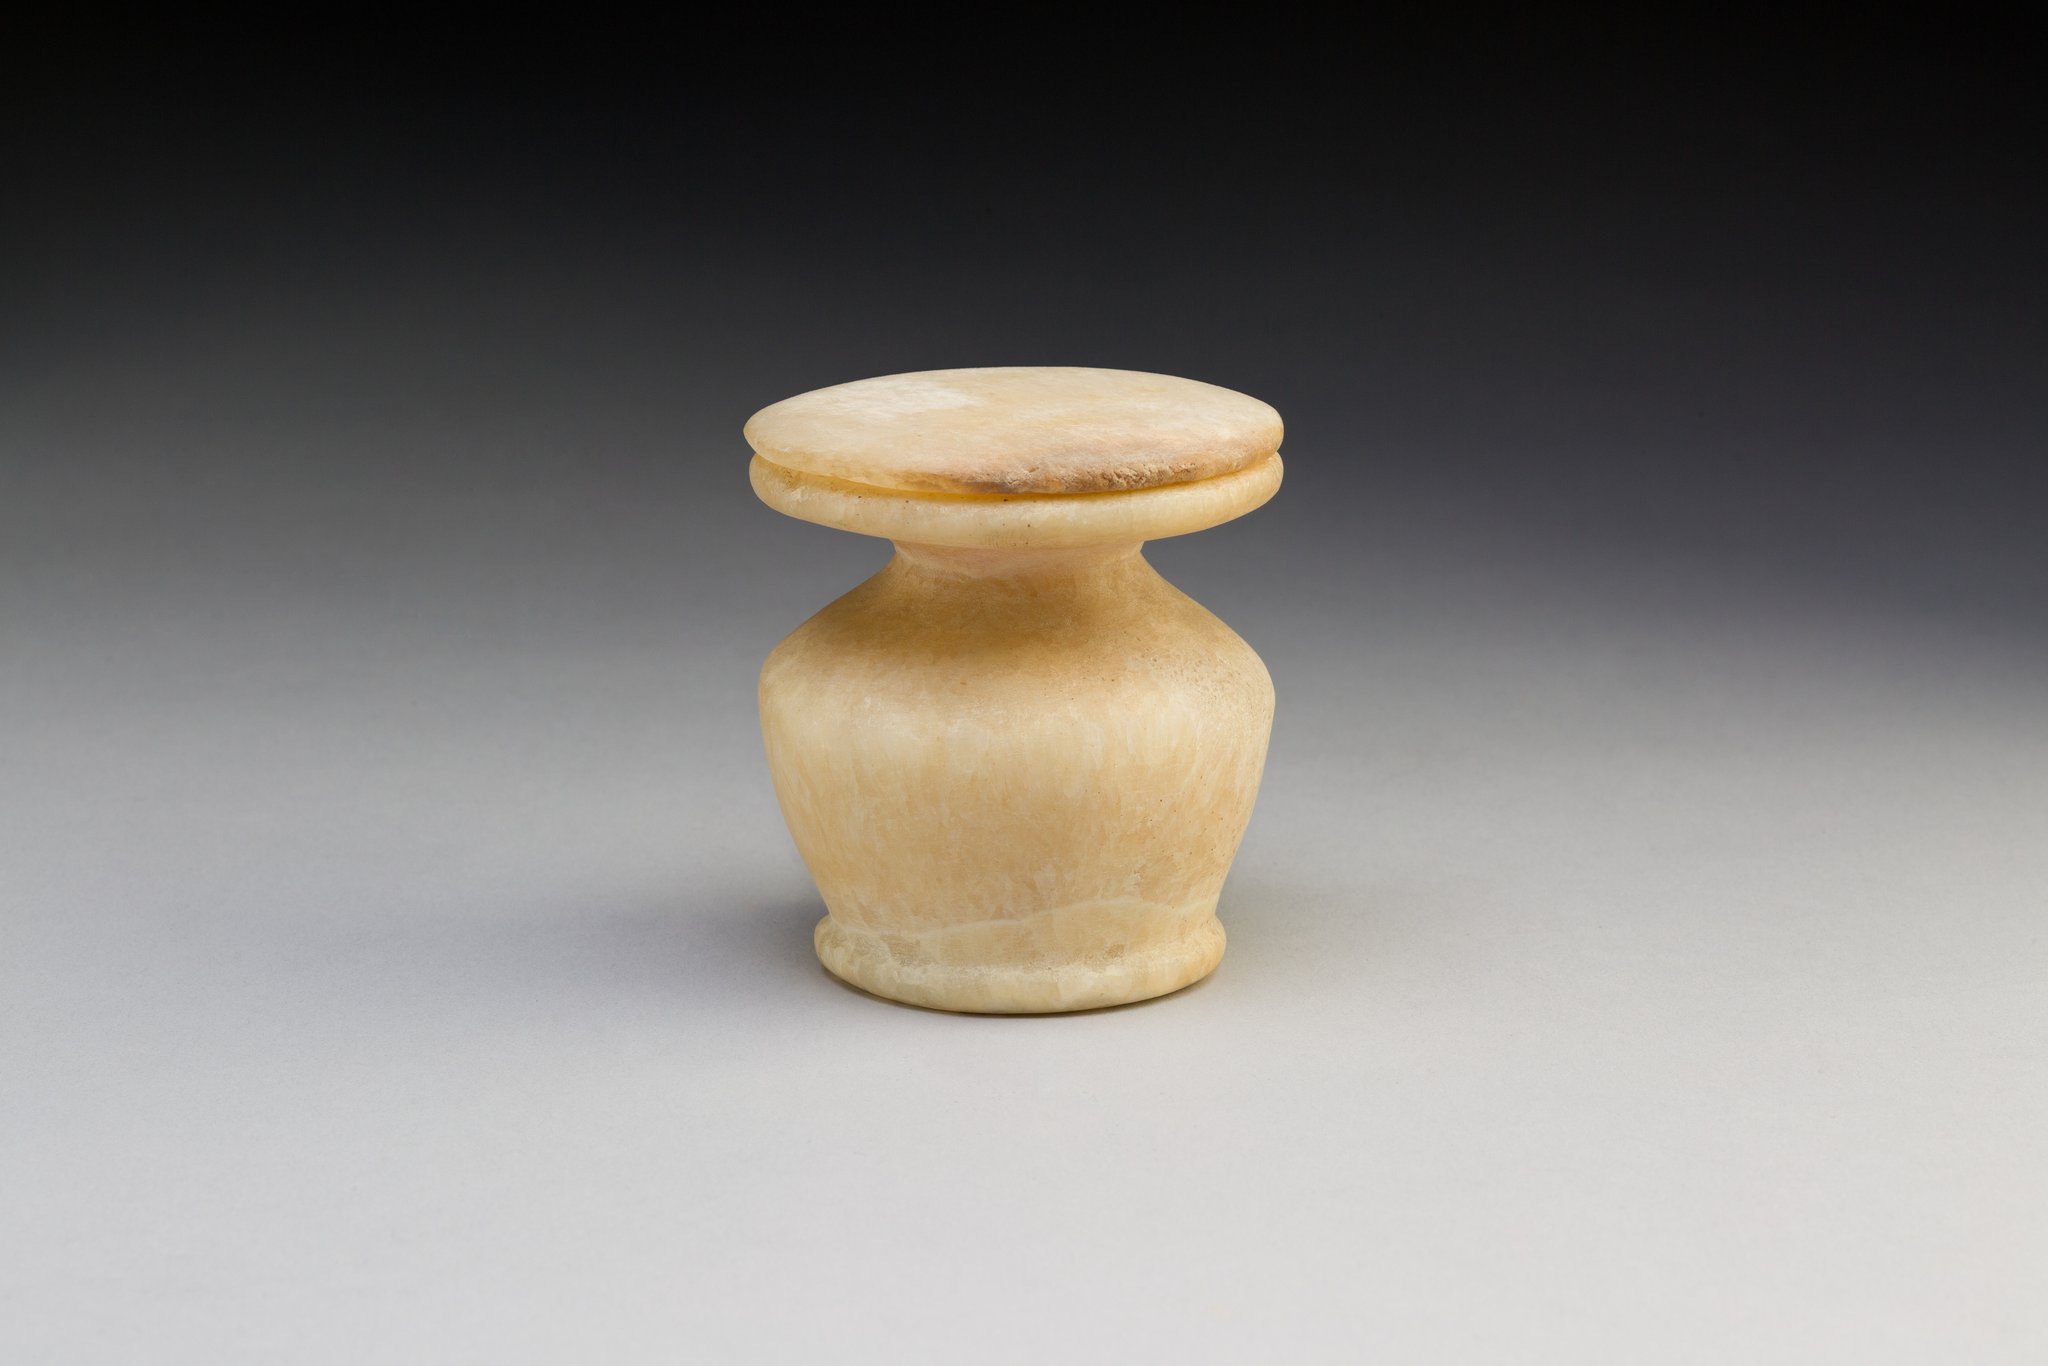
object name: kohl jar, amenemhat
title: Kohl Jar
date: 1504-1447 BCE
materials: stone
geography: egypt